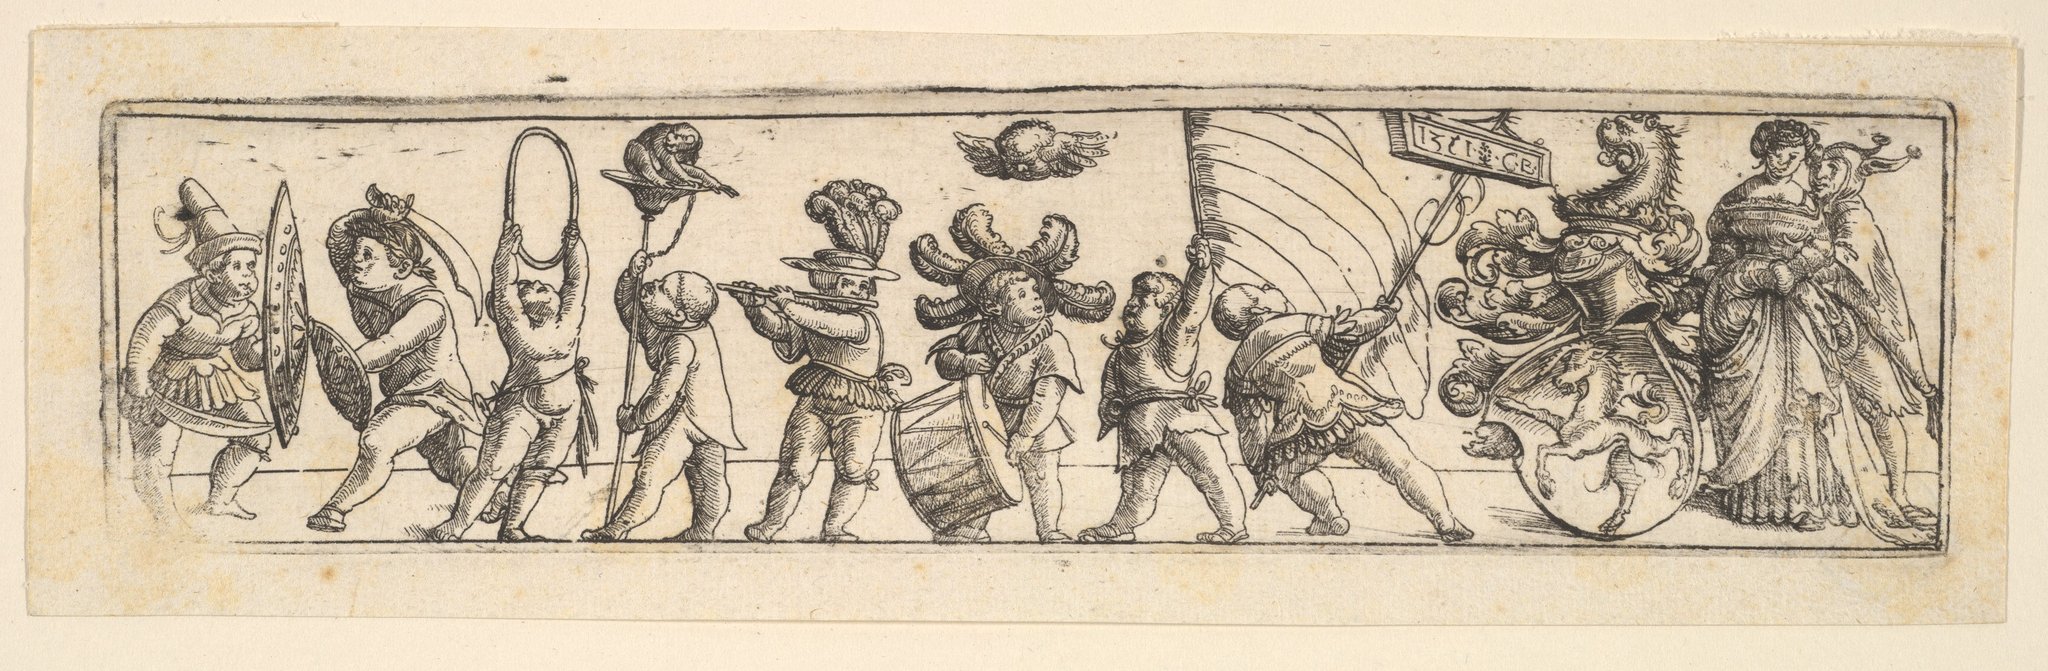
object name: print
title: Frieze with children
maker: christoph bockstorffer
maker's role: artist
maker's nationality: german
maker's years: 1475-1558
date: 1531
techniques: etching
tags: musical instruments,children